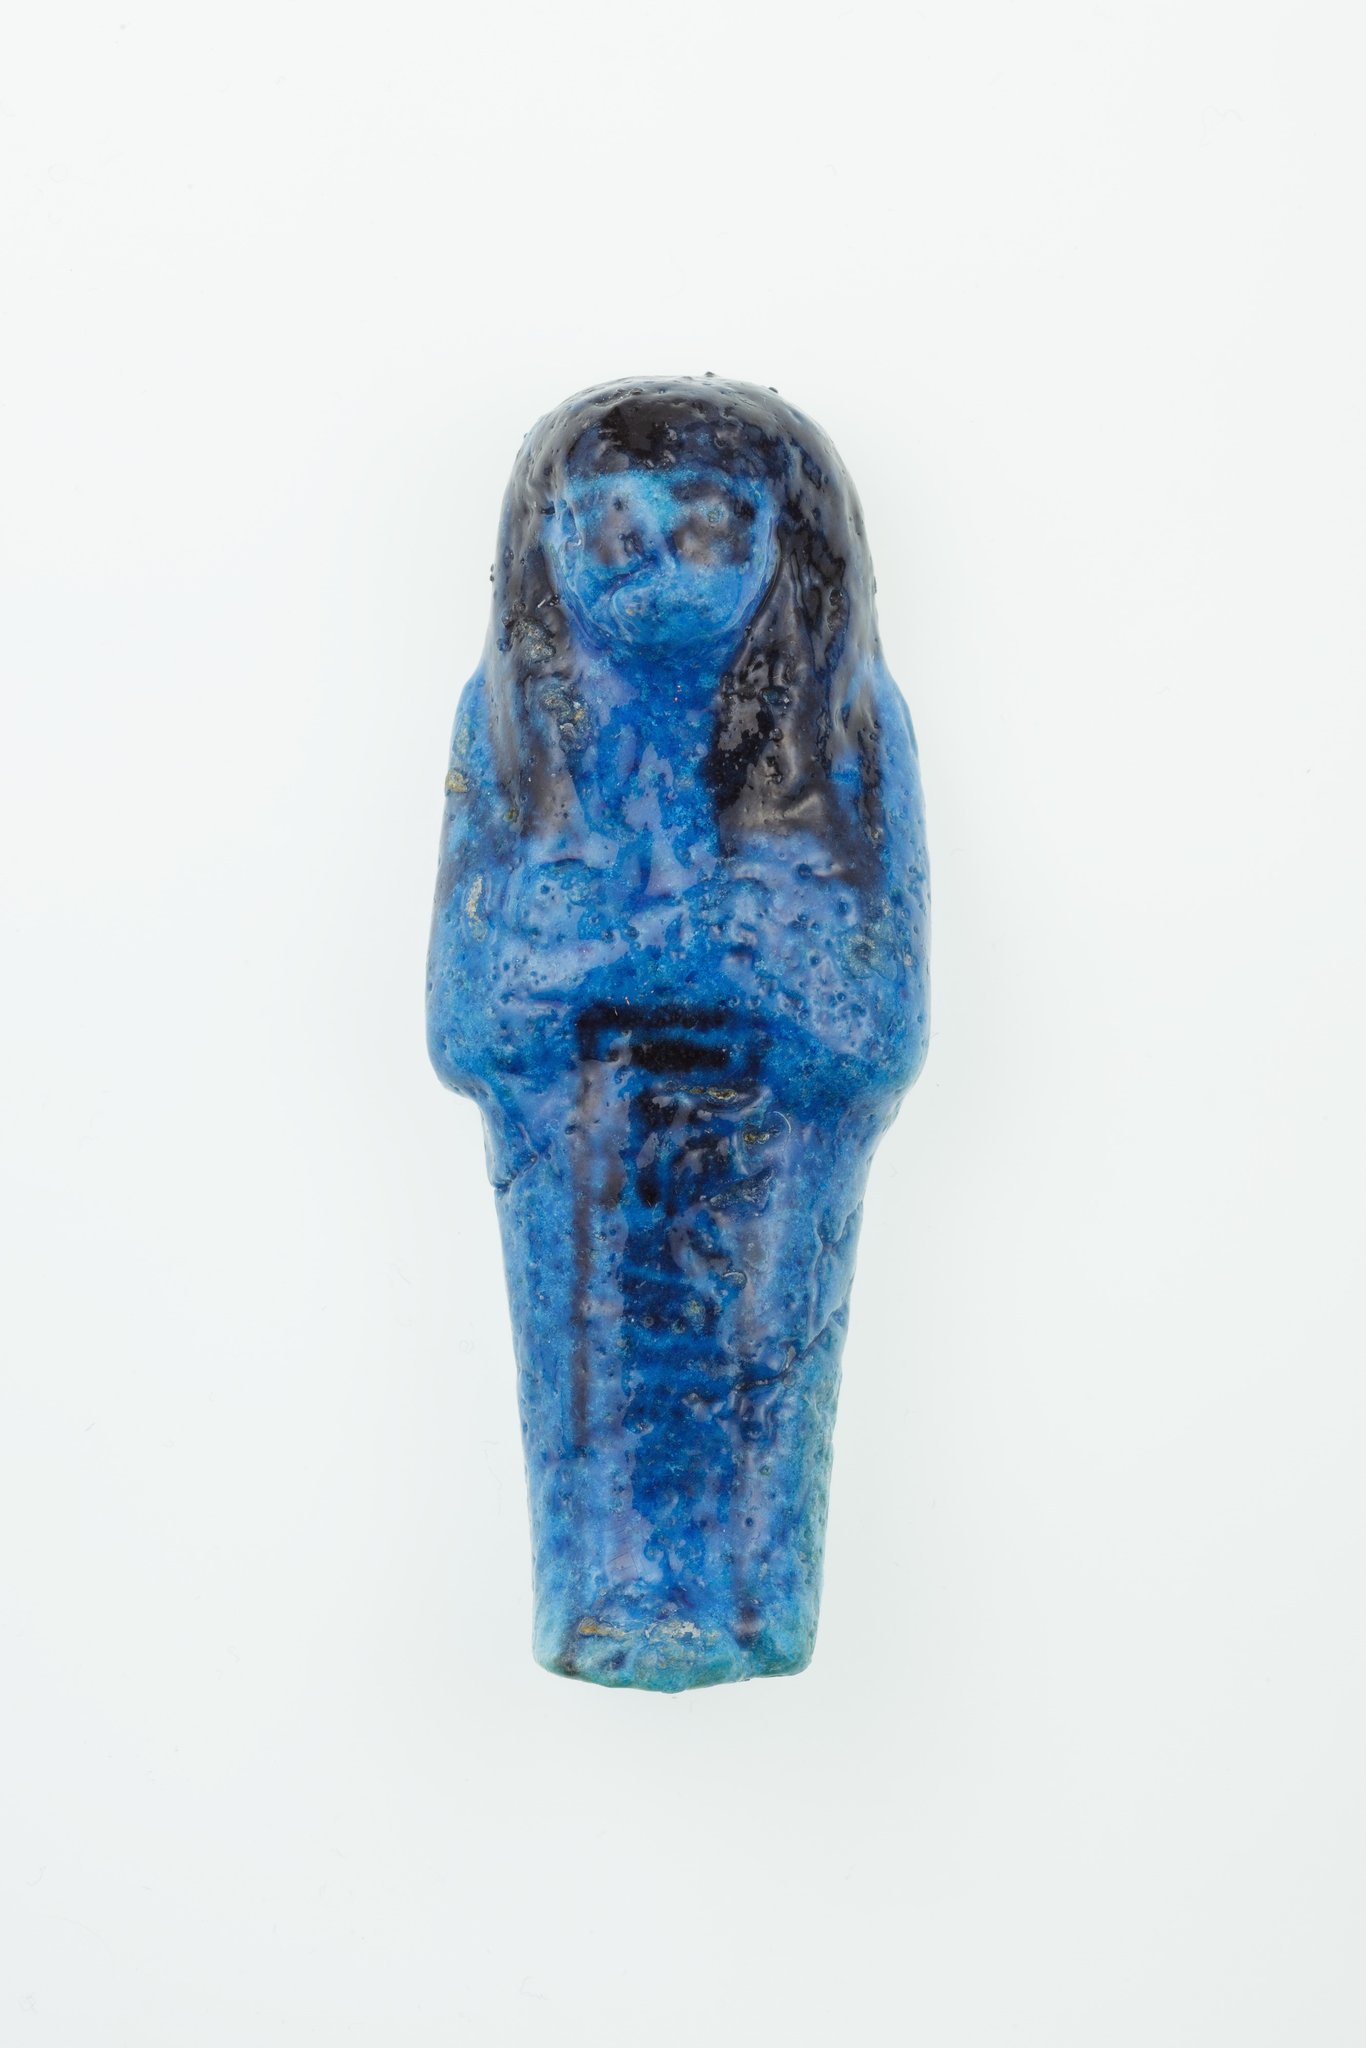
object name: shabti, nauny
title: Worker Shabti of Nauny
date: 1050 BCE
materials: faience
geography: egypt